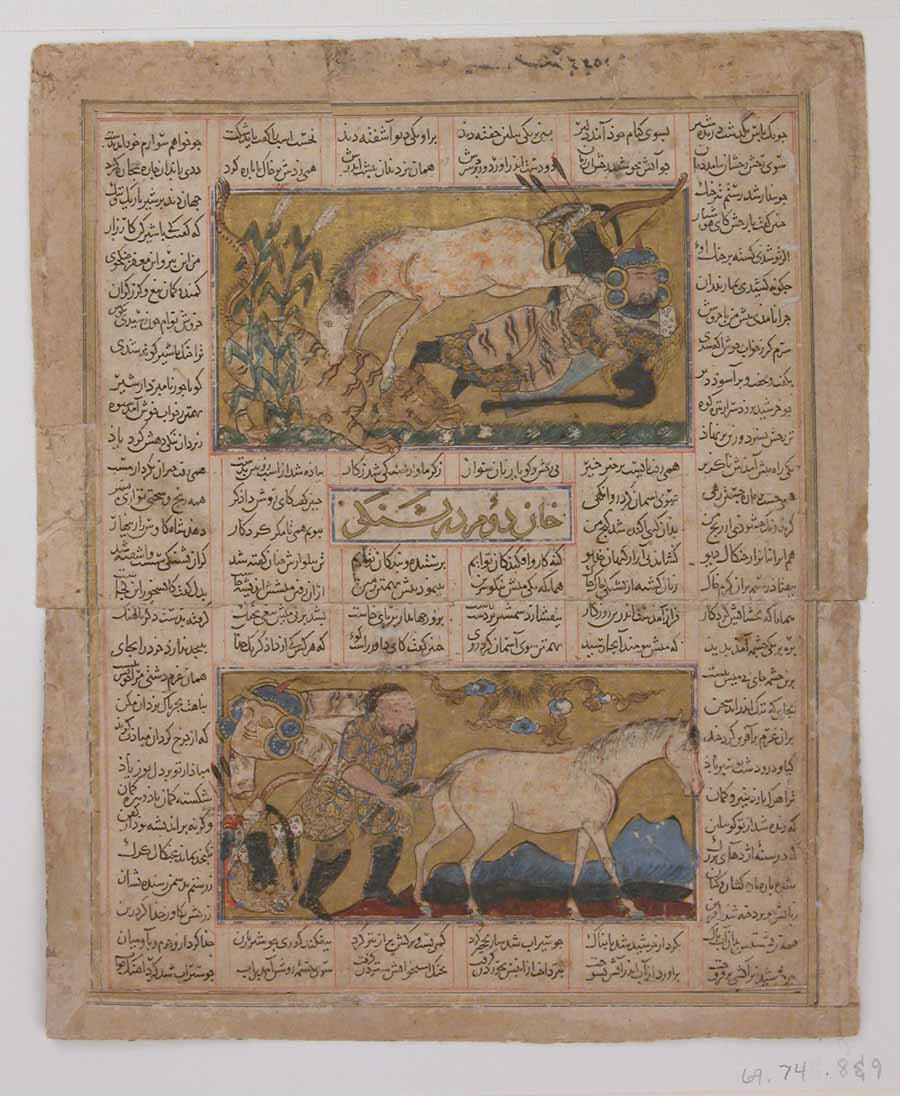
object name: folio from an illustrated manuscript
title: "Rakhsh Kills a Lion while Rustam is Asleep", Folio from a Shahnama (Book of Kings) of Firdausi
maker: abu'l qasim firdausi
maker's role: author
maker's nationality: iranian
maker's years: 935-1020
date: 1300-1330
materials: gold, ink, paper, silver, watercolor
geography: iran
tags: men,horses,lions